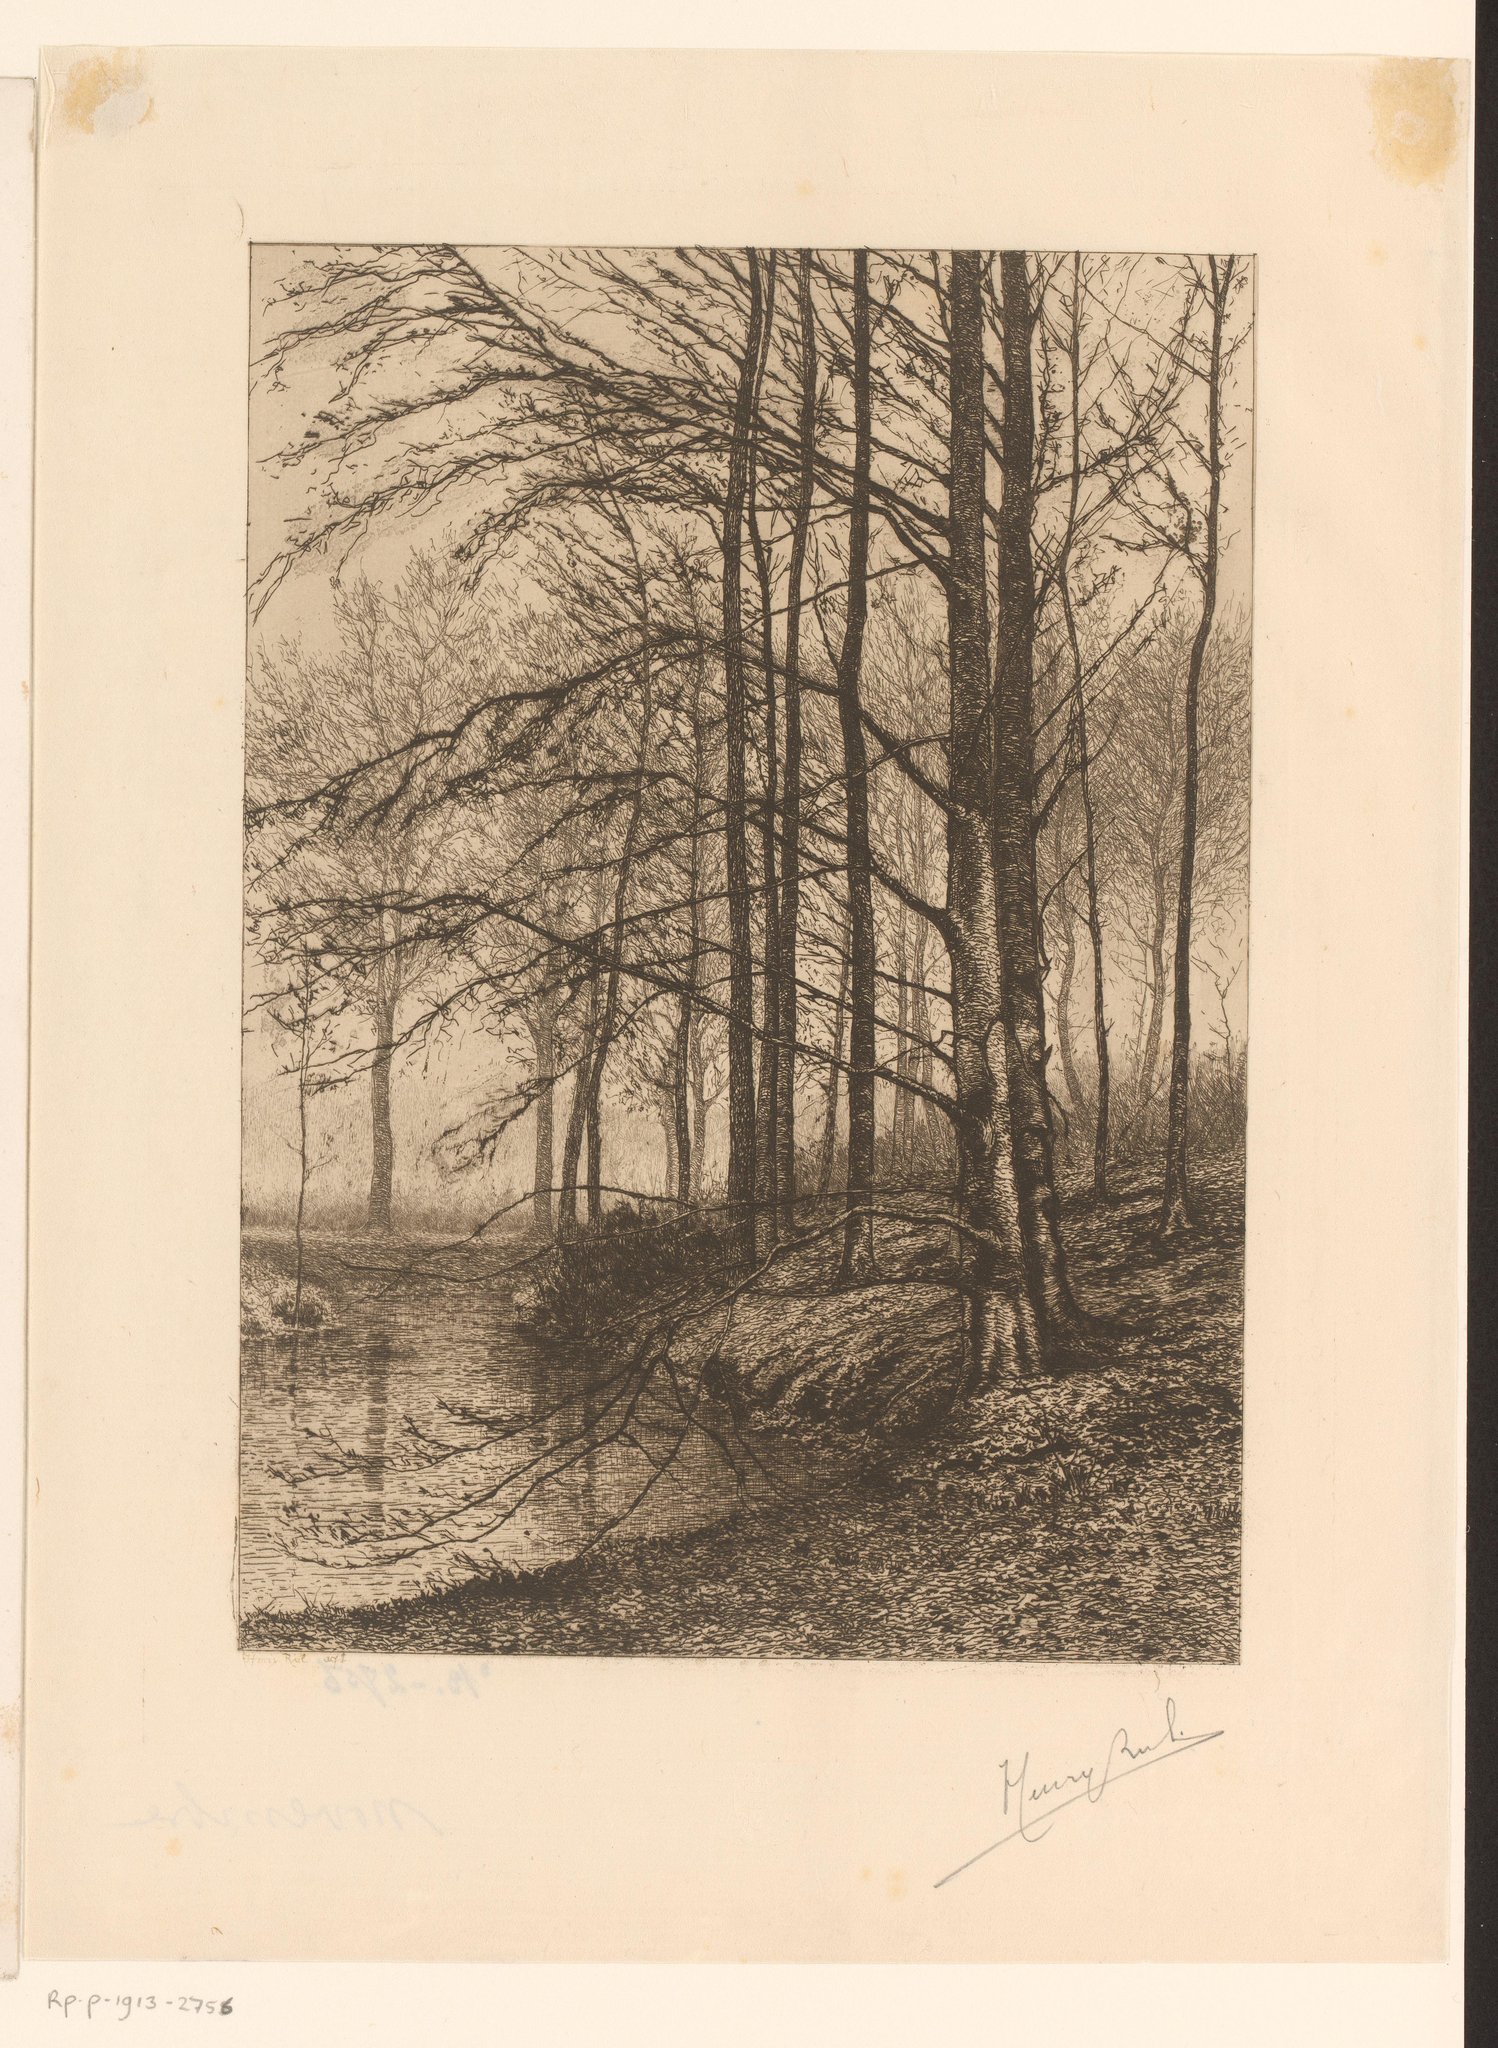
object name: print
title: Herfstbos met sloot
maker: henri rul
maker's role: print maker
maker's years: 1862-1942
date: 1872-1913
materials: paper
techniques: etching, retroussage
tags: forest, wood, brook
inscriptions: mark: ‘Antwerpsche Etsers 1880’, collector's mark: Lugt 2228